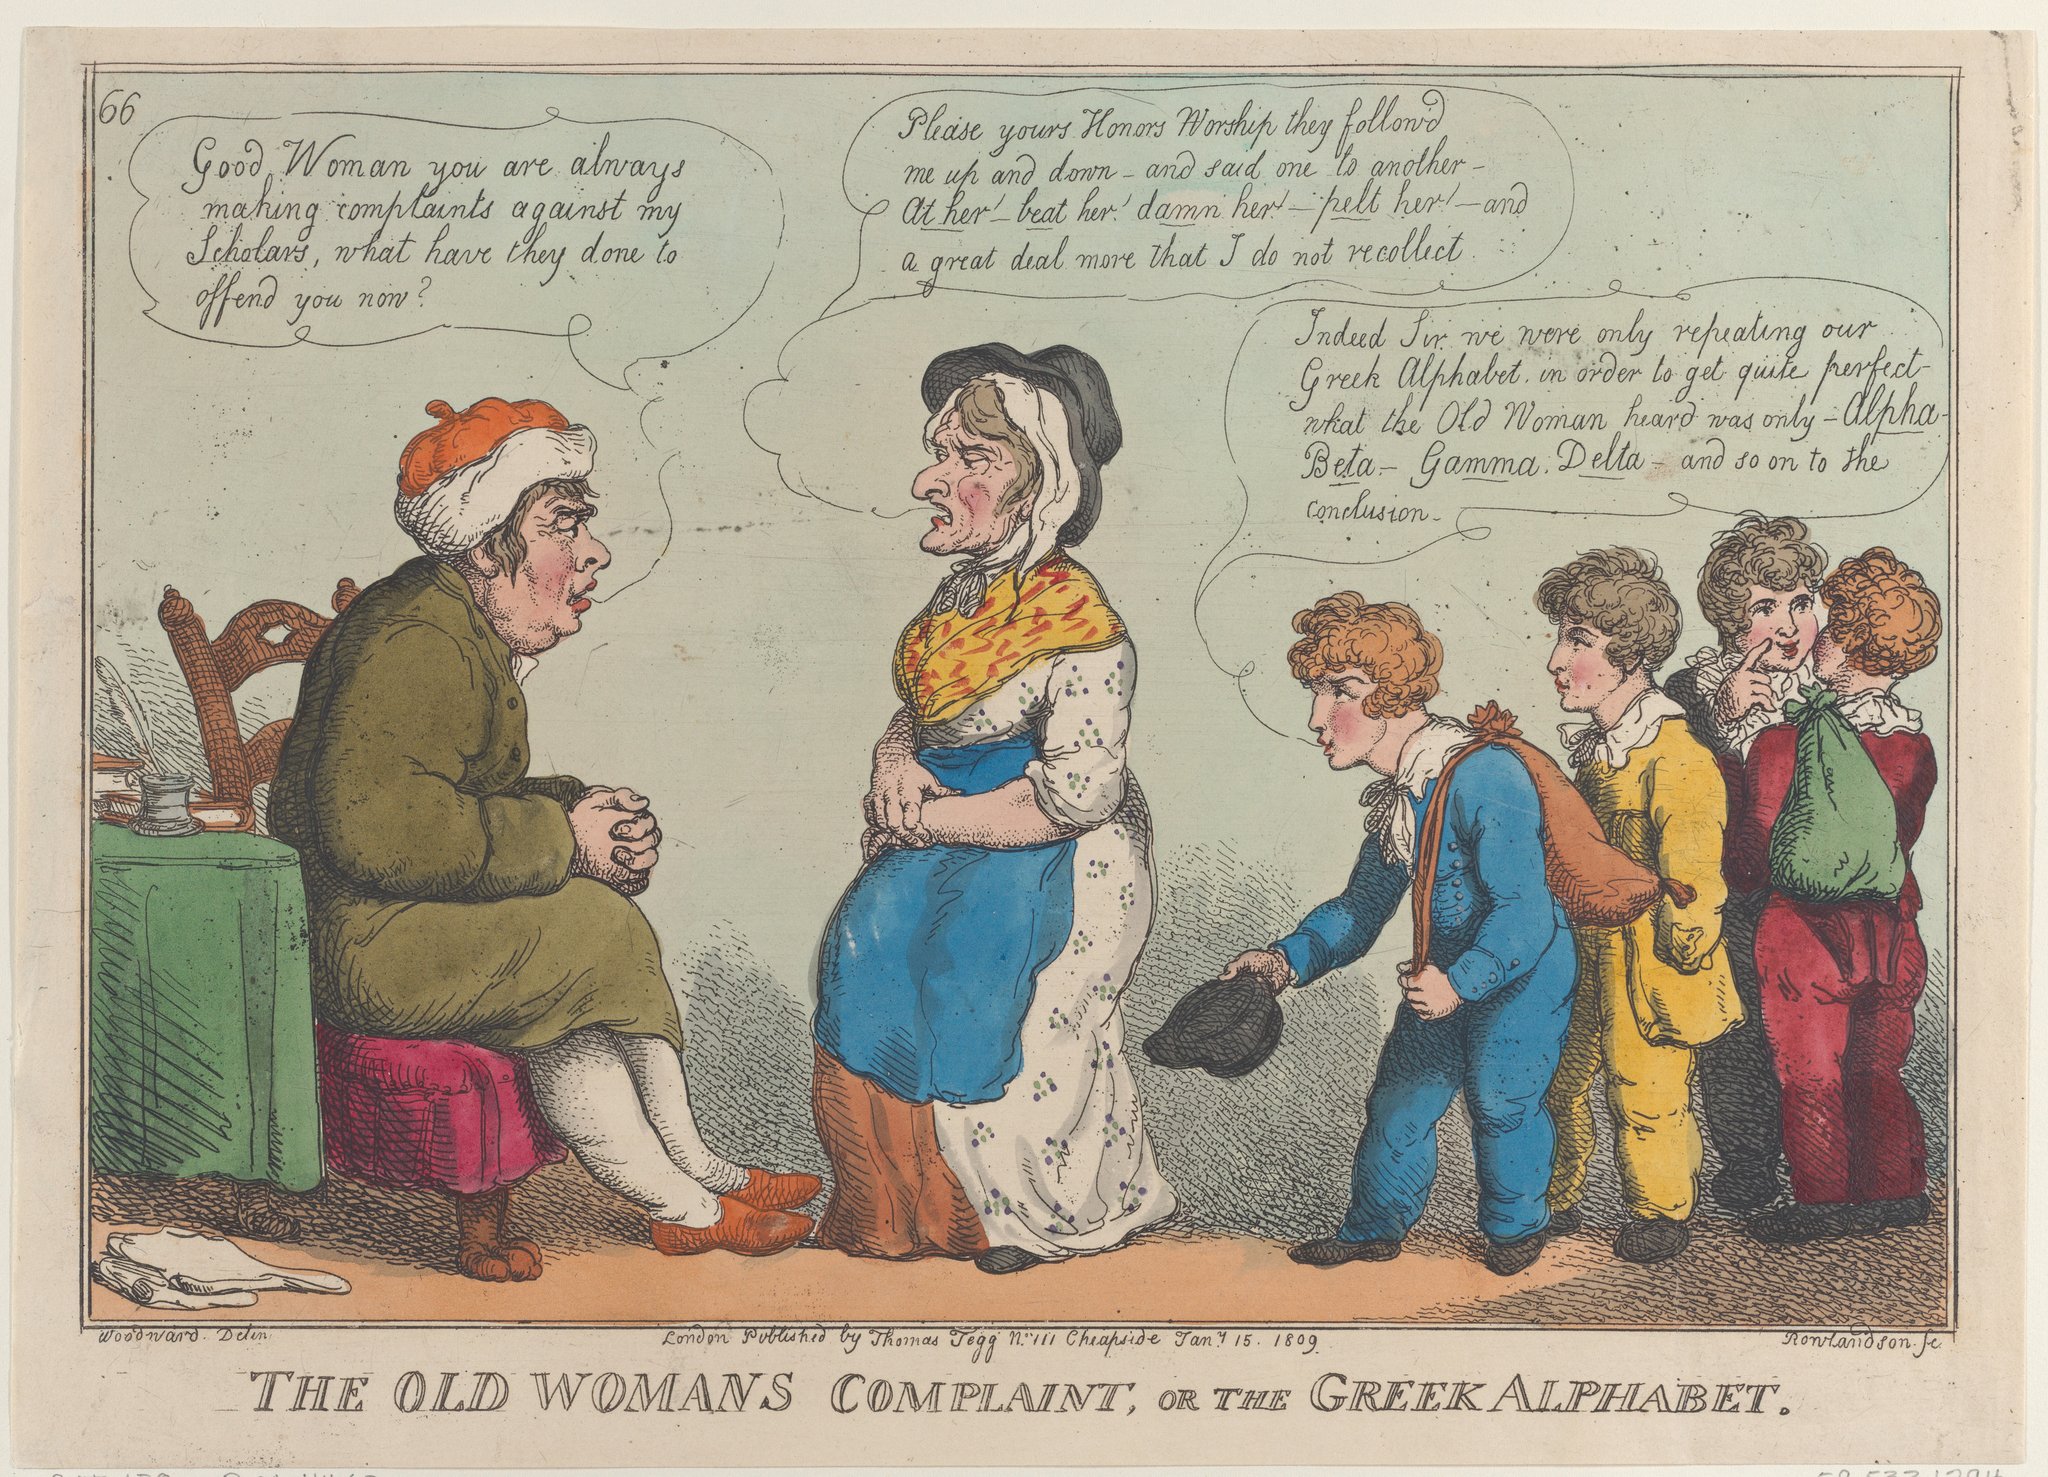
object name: print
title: The Old Womans Complaint, or the Greek Alphabet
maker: thomas rowlandson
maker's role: artist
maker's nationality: british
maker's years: 1757-1827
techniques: etching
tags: satire,boys,men,women